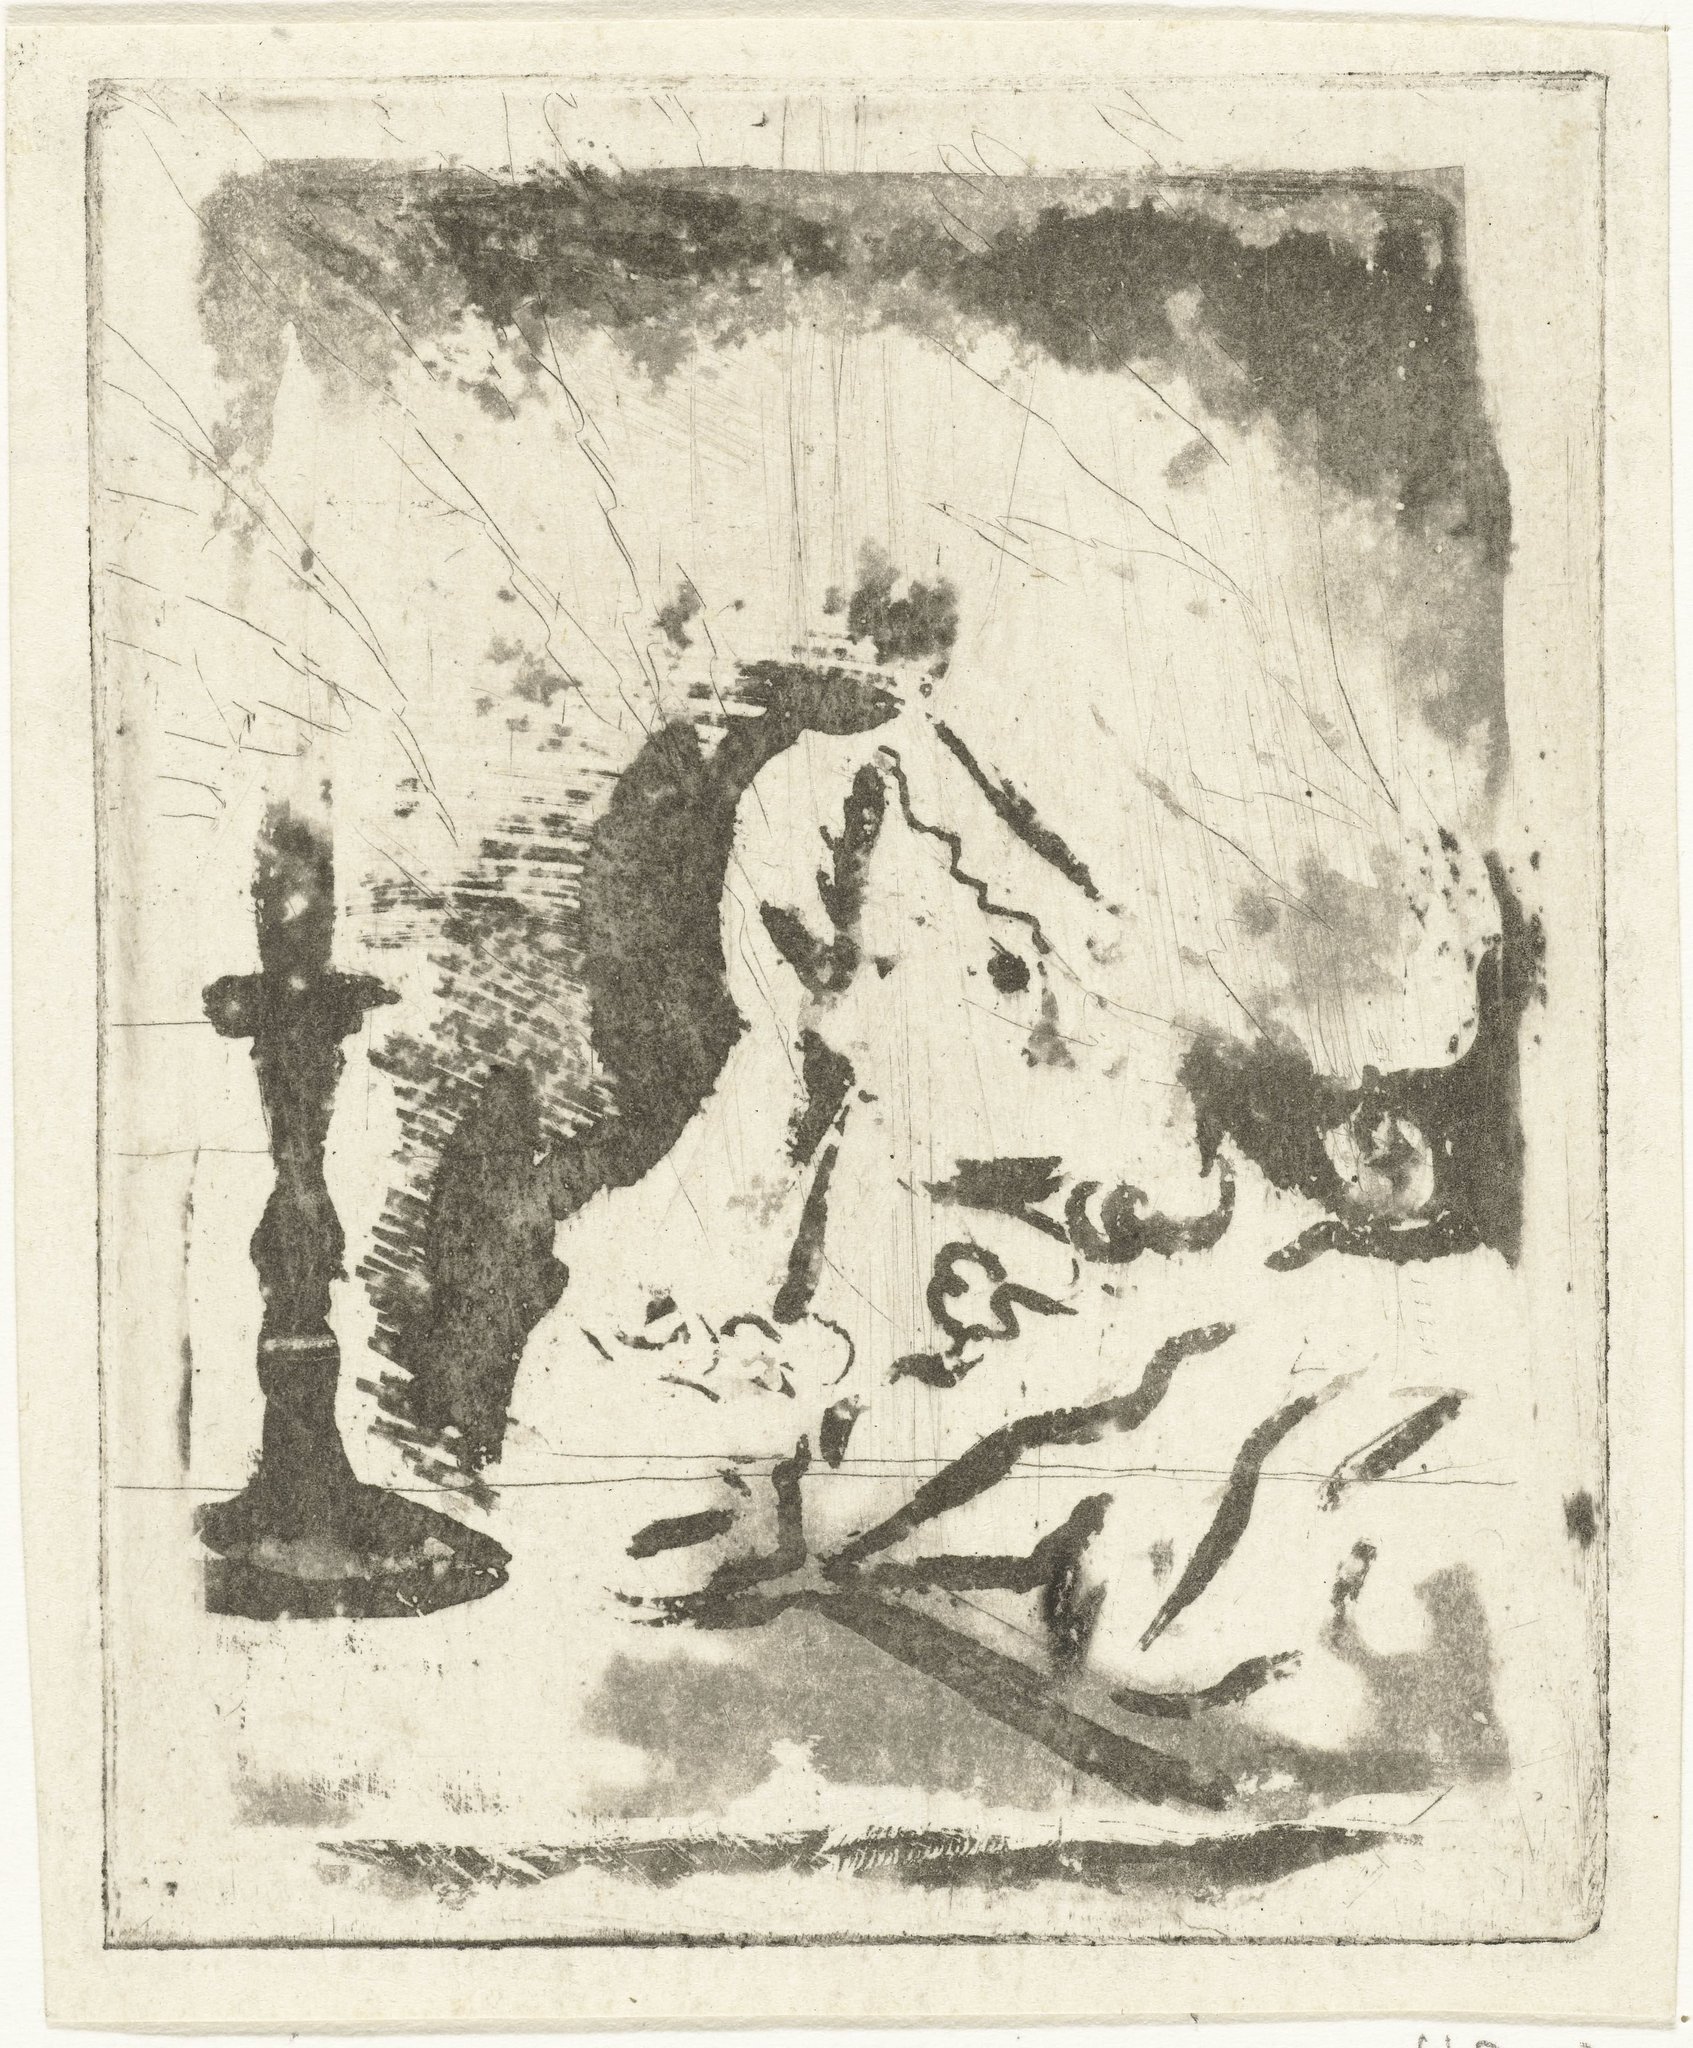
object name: print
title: Studieblad met kandelaar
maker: louis bernard coclers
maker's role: draughtsman, print maker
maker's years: 1741-1817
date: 1756-1817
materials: paper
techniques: sugar lift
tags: candlestick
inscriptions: collector's mark: Lugt 2228